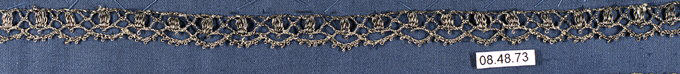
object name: fragment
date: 1801-1900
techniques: lace